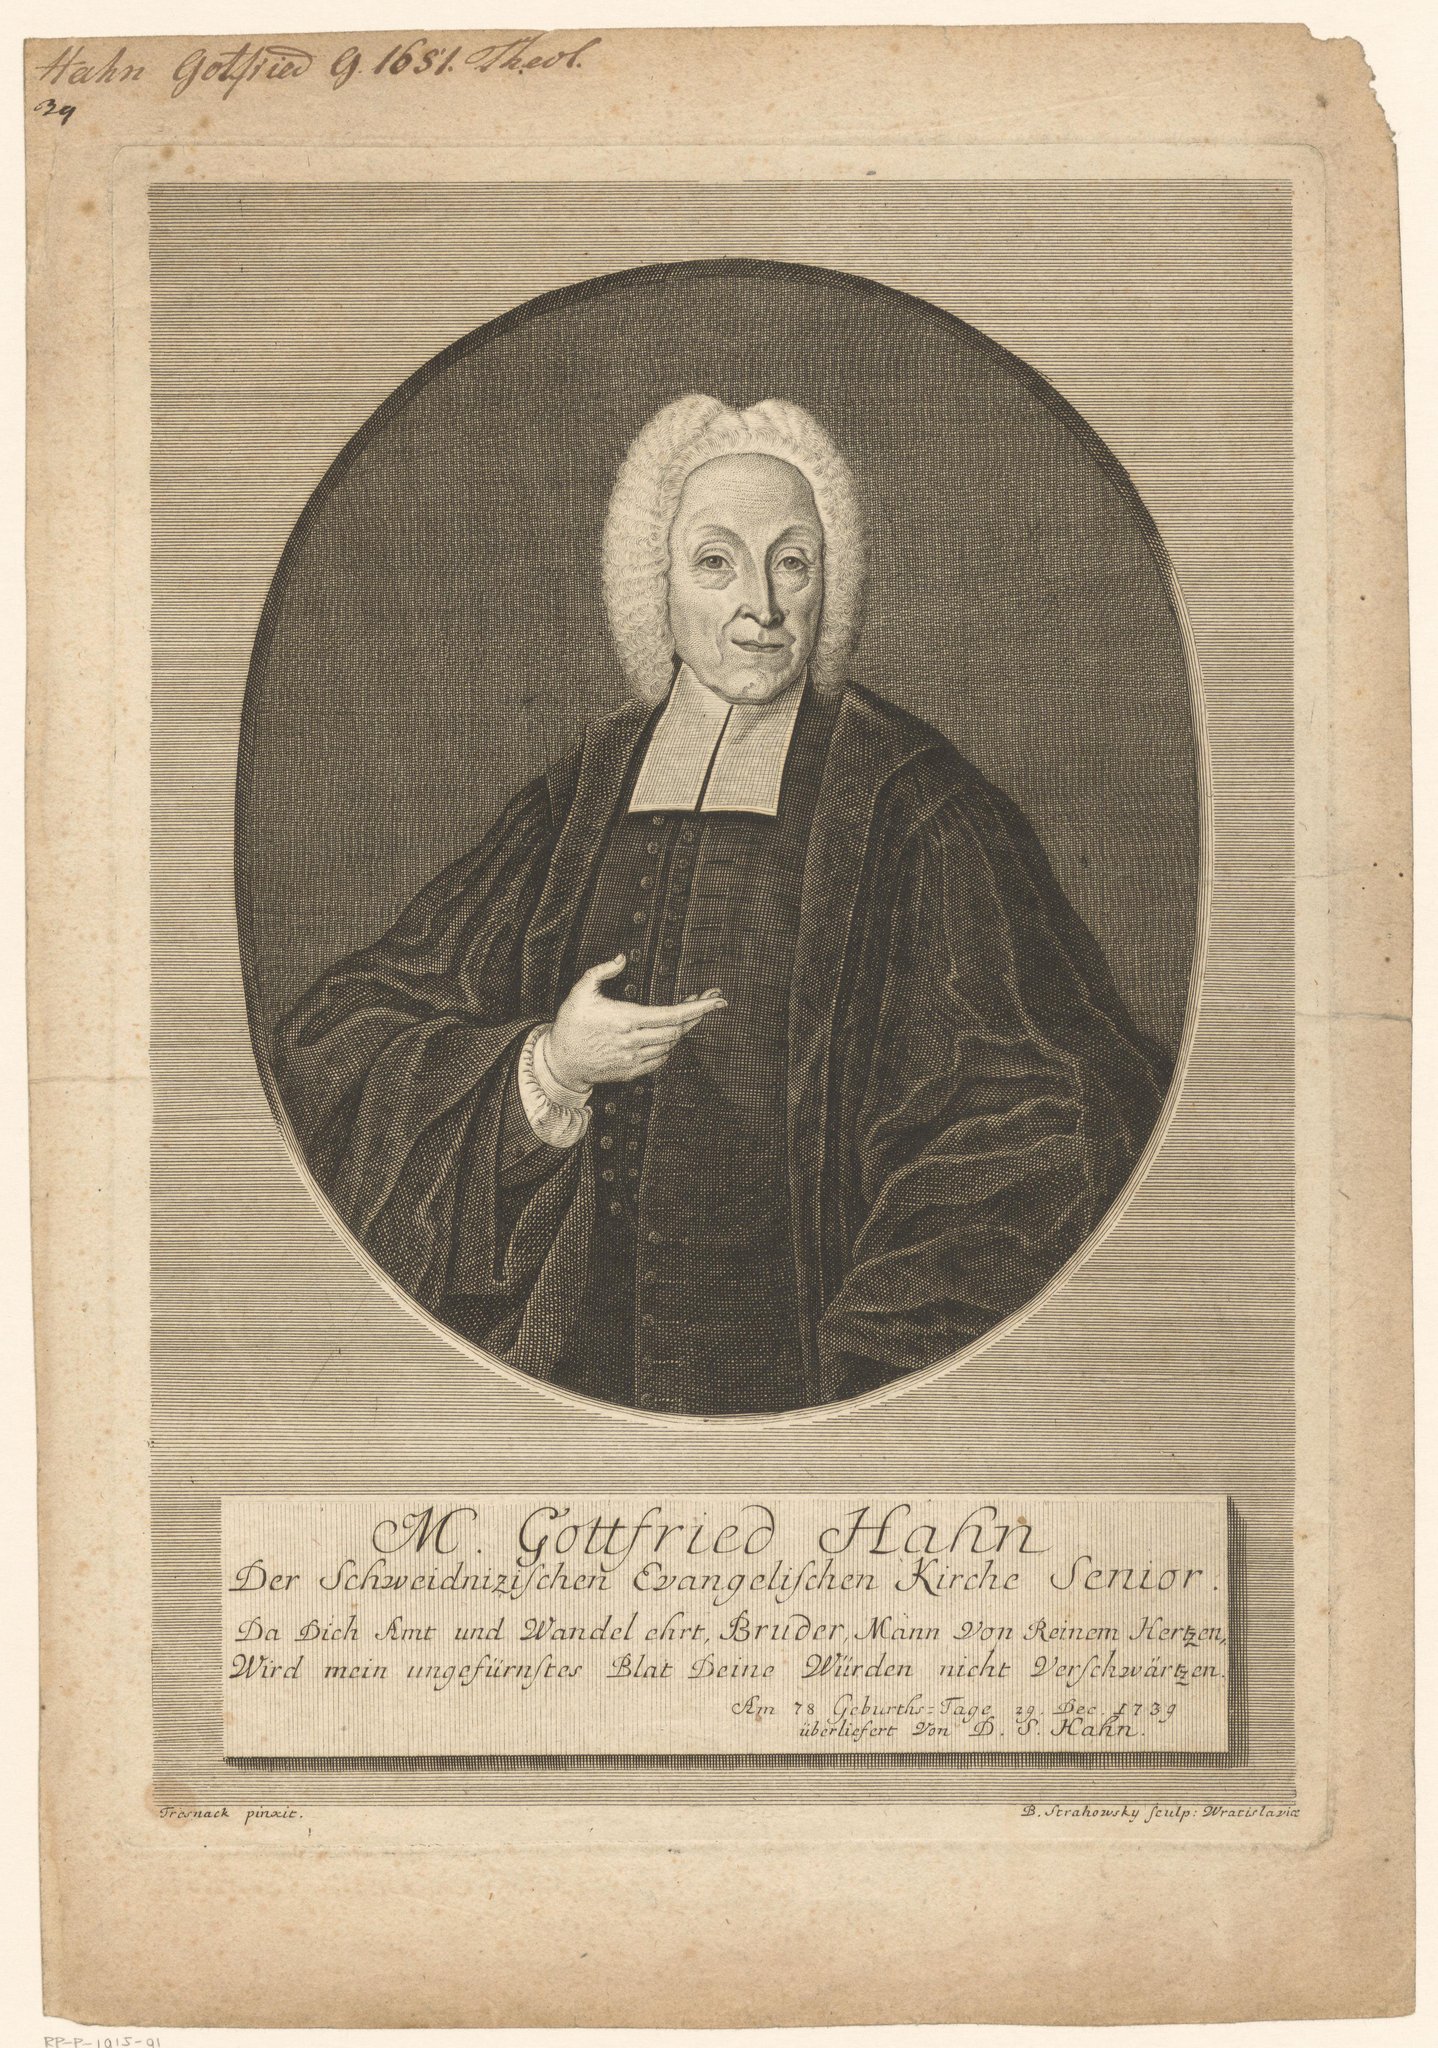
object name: print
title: Portret van Gottfried Hahn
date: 1739-1759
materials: paper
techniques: engraving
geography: breslau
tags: historical persons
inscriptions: number: ‘39’, collector's mark: Lugt 2228